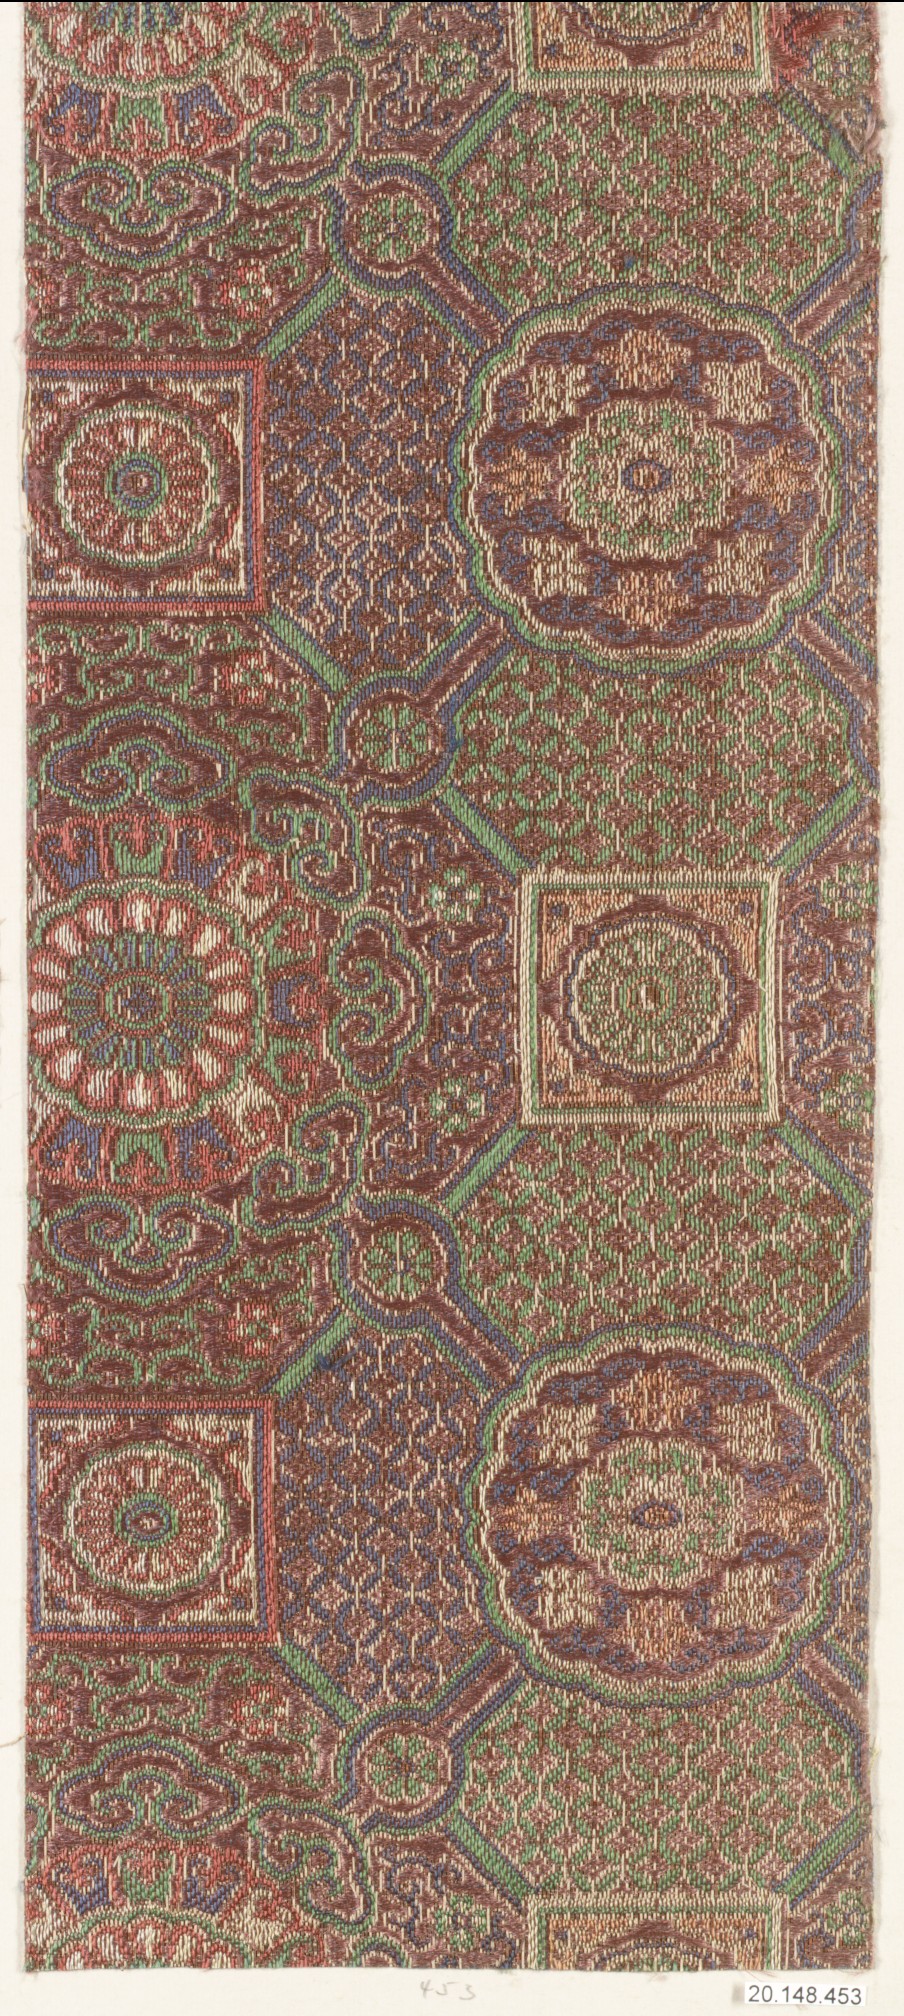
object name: piece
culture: china or japan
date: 1801-1900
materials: silk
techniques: compound weave